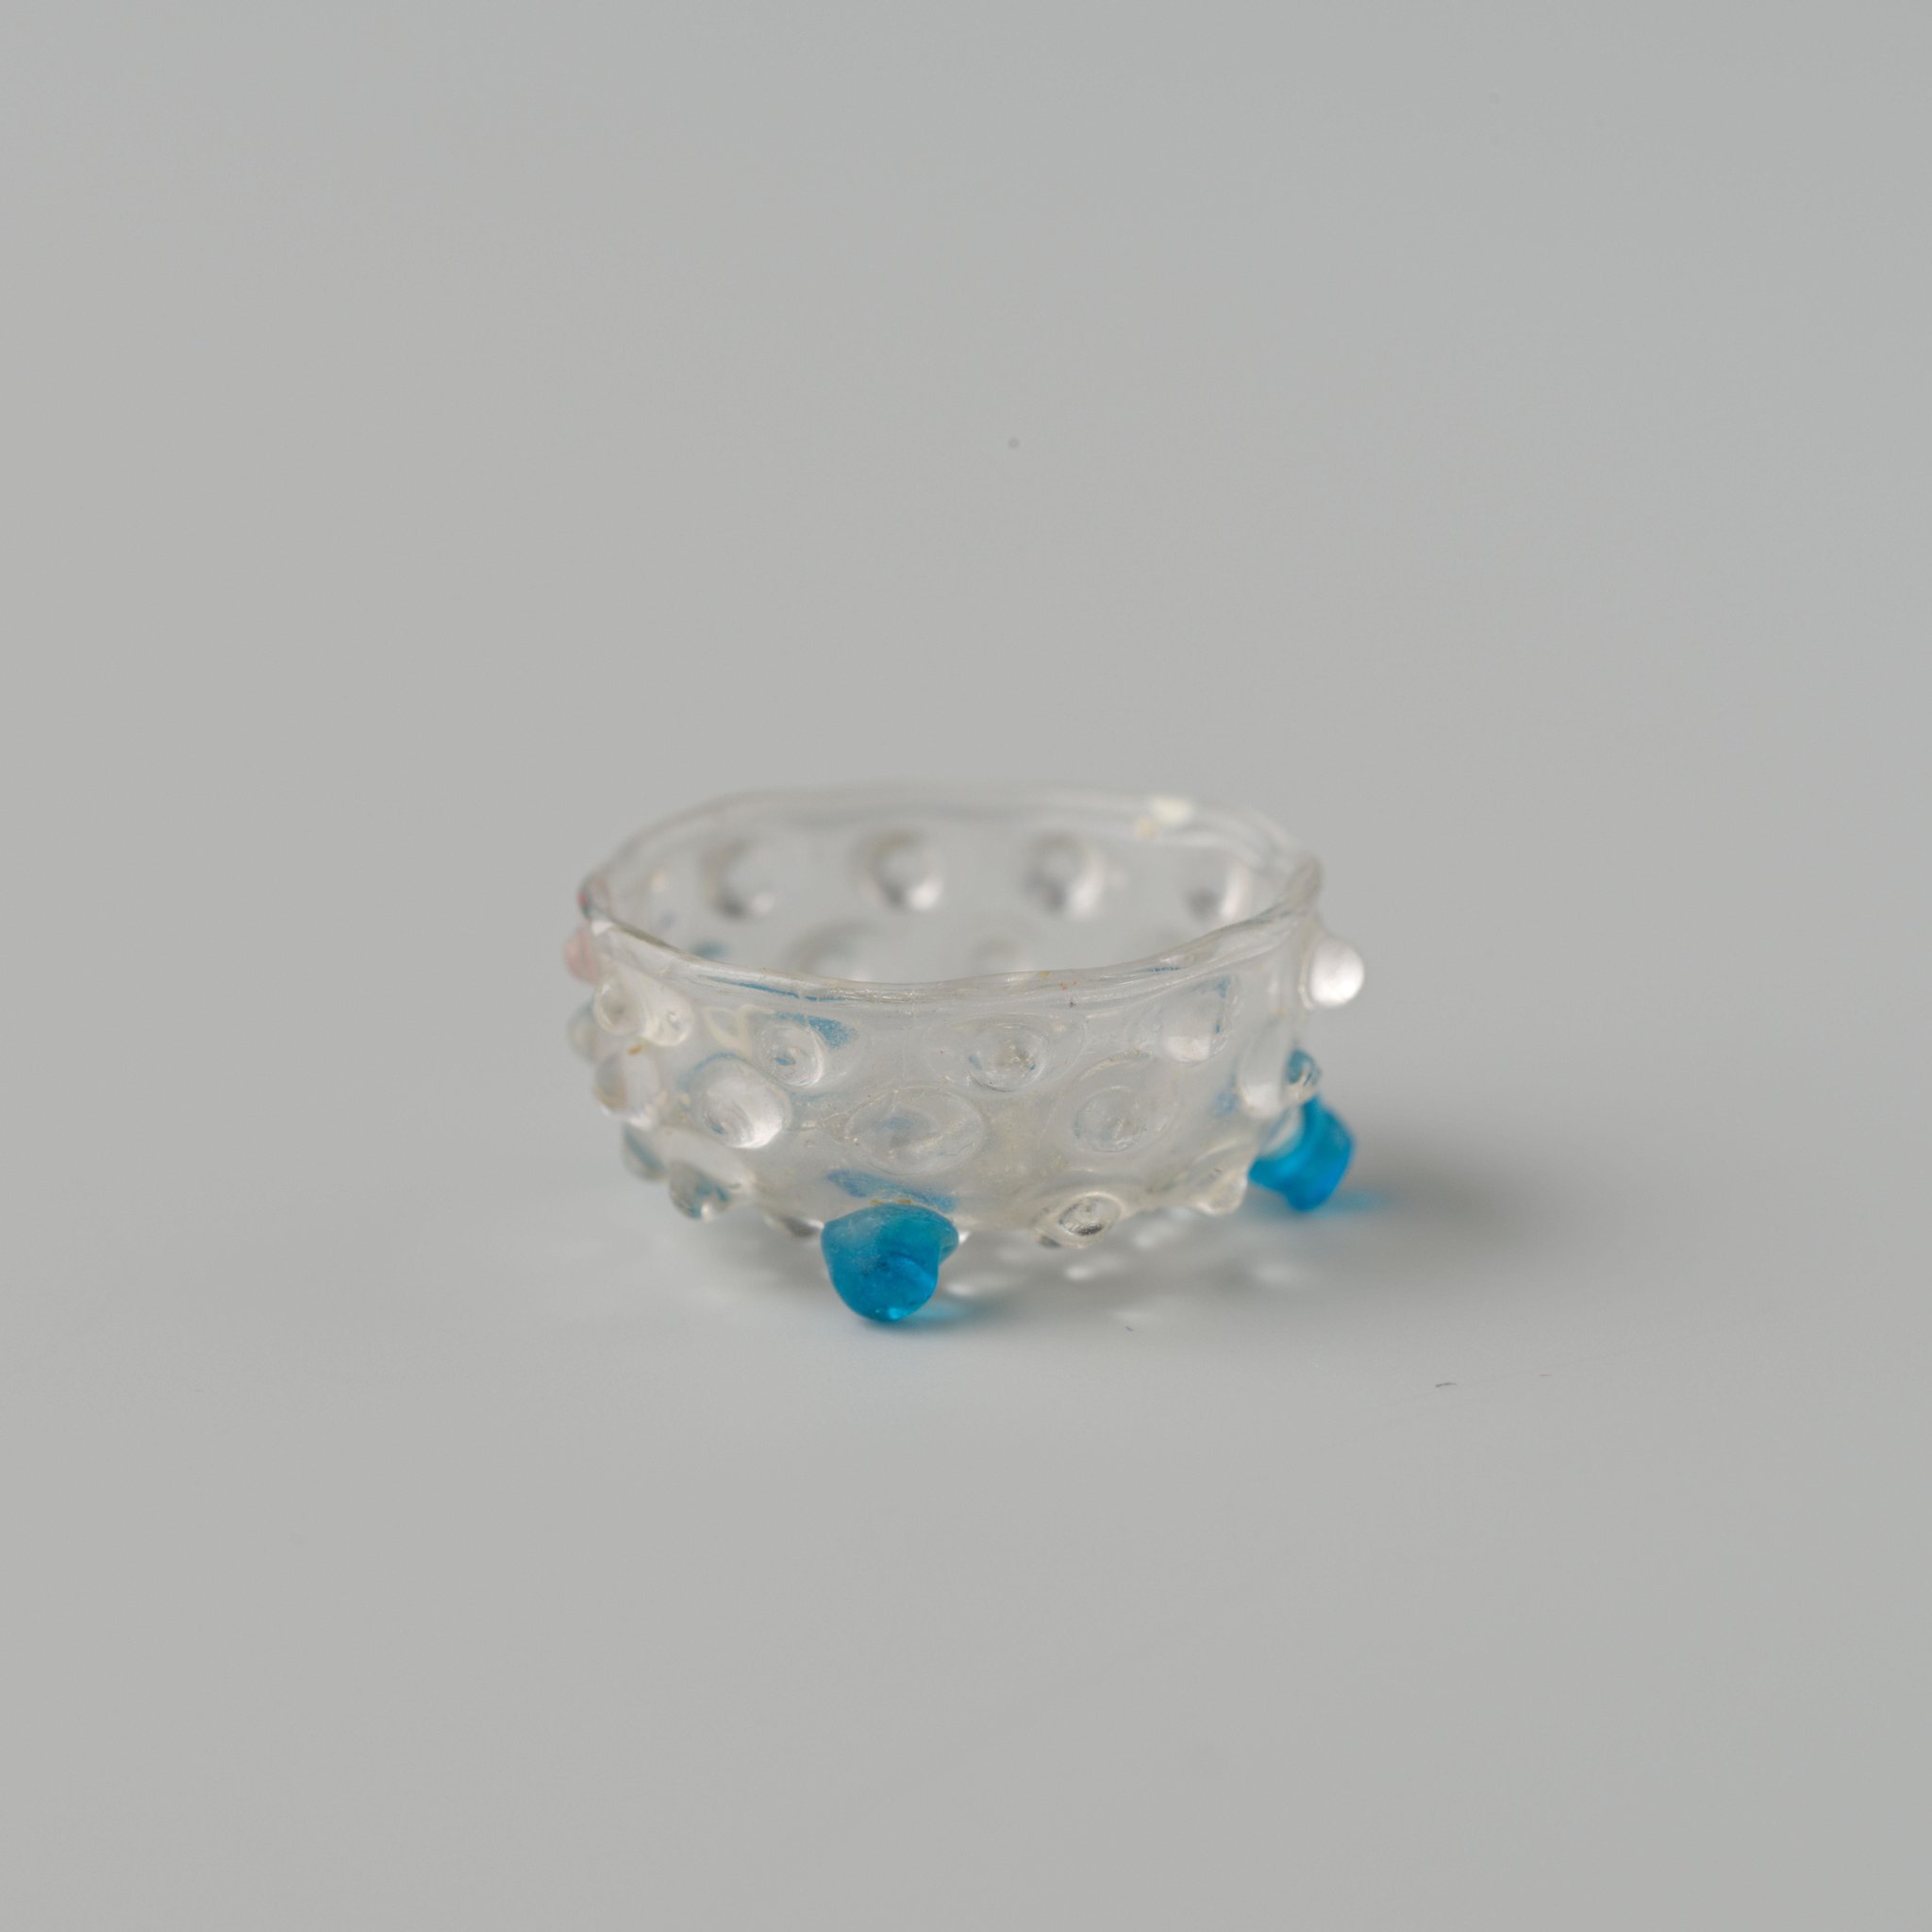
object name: miniature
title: Nap van helder kleurloos glas versierd met wratten of noppen, staand op drie blauwe bolpootjes.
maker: Anonymous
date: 1675-1710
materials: glass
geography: amsterdam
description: Nap van helder kleurloos glas versierd met wratten of knoppen, staand op drie blauwe bolpootjes.